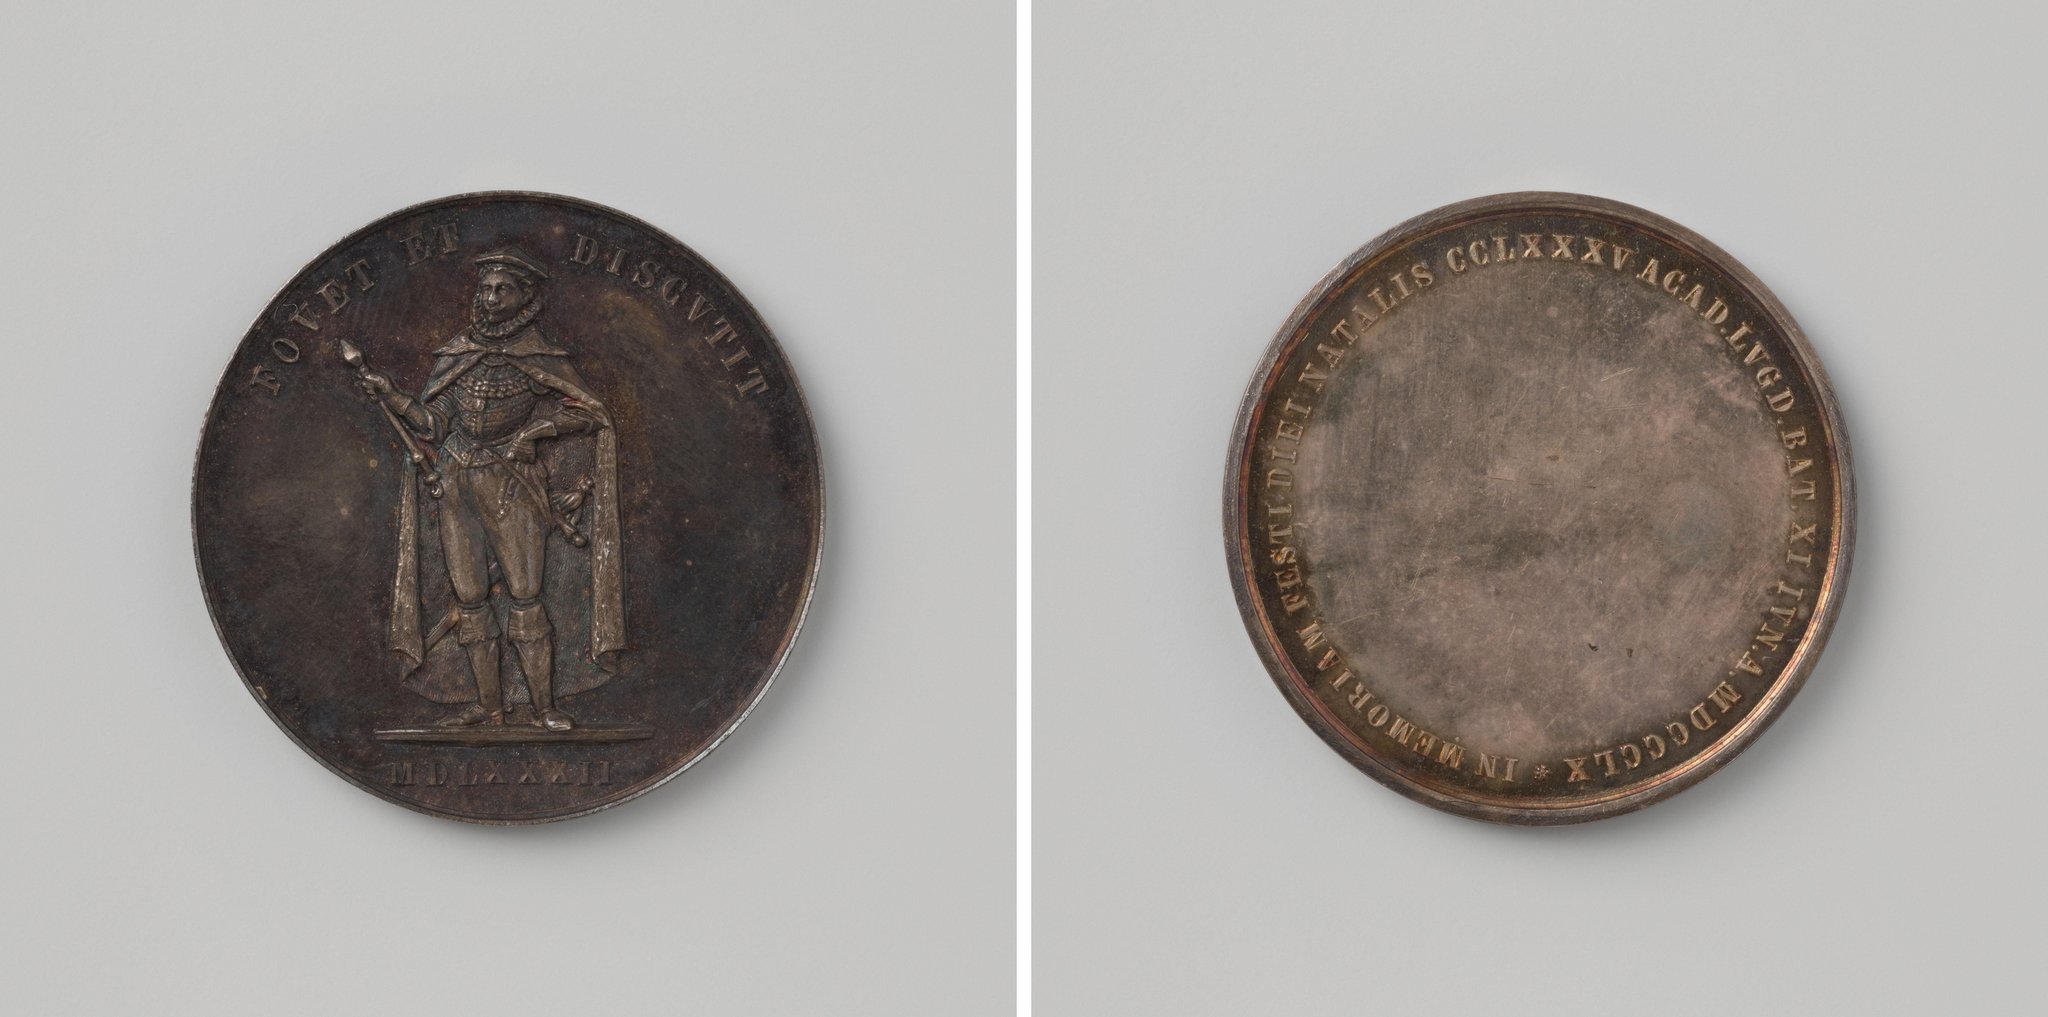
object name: history medal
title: Gemaskerde optocht door de studenten, ter herdenking van de hertog van Anjou, ter ere van de 285e stichtingsdag van de Universiteit van Leiden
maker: Anonymous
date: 1860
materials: silver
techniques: striking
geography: netherlands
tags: paris, françois-hercule de valois (hertog van anjou), leiden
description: Zilveren penning. Voorzijde: portret man met scepter binnen omschrift; afsnede: jaartal. Keerzijde: blanco veld binnen omschrift